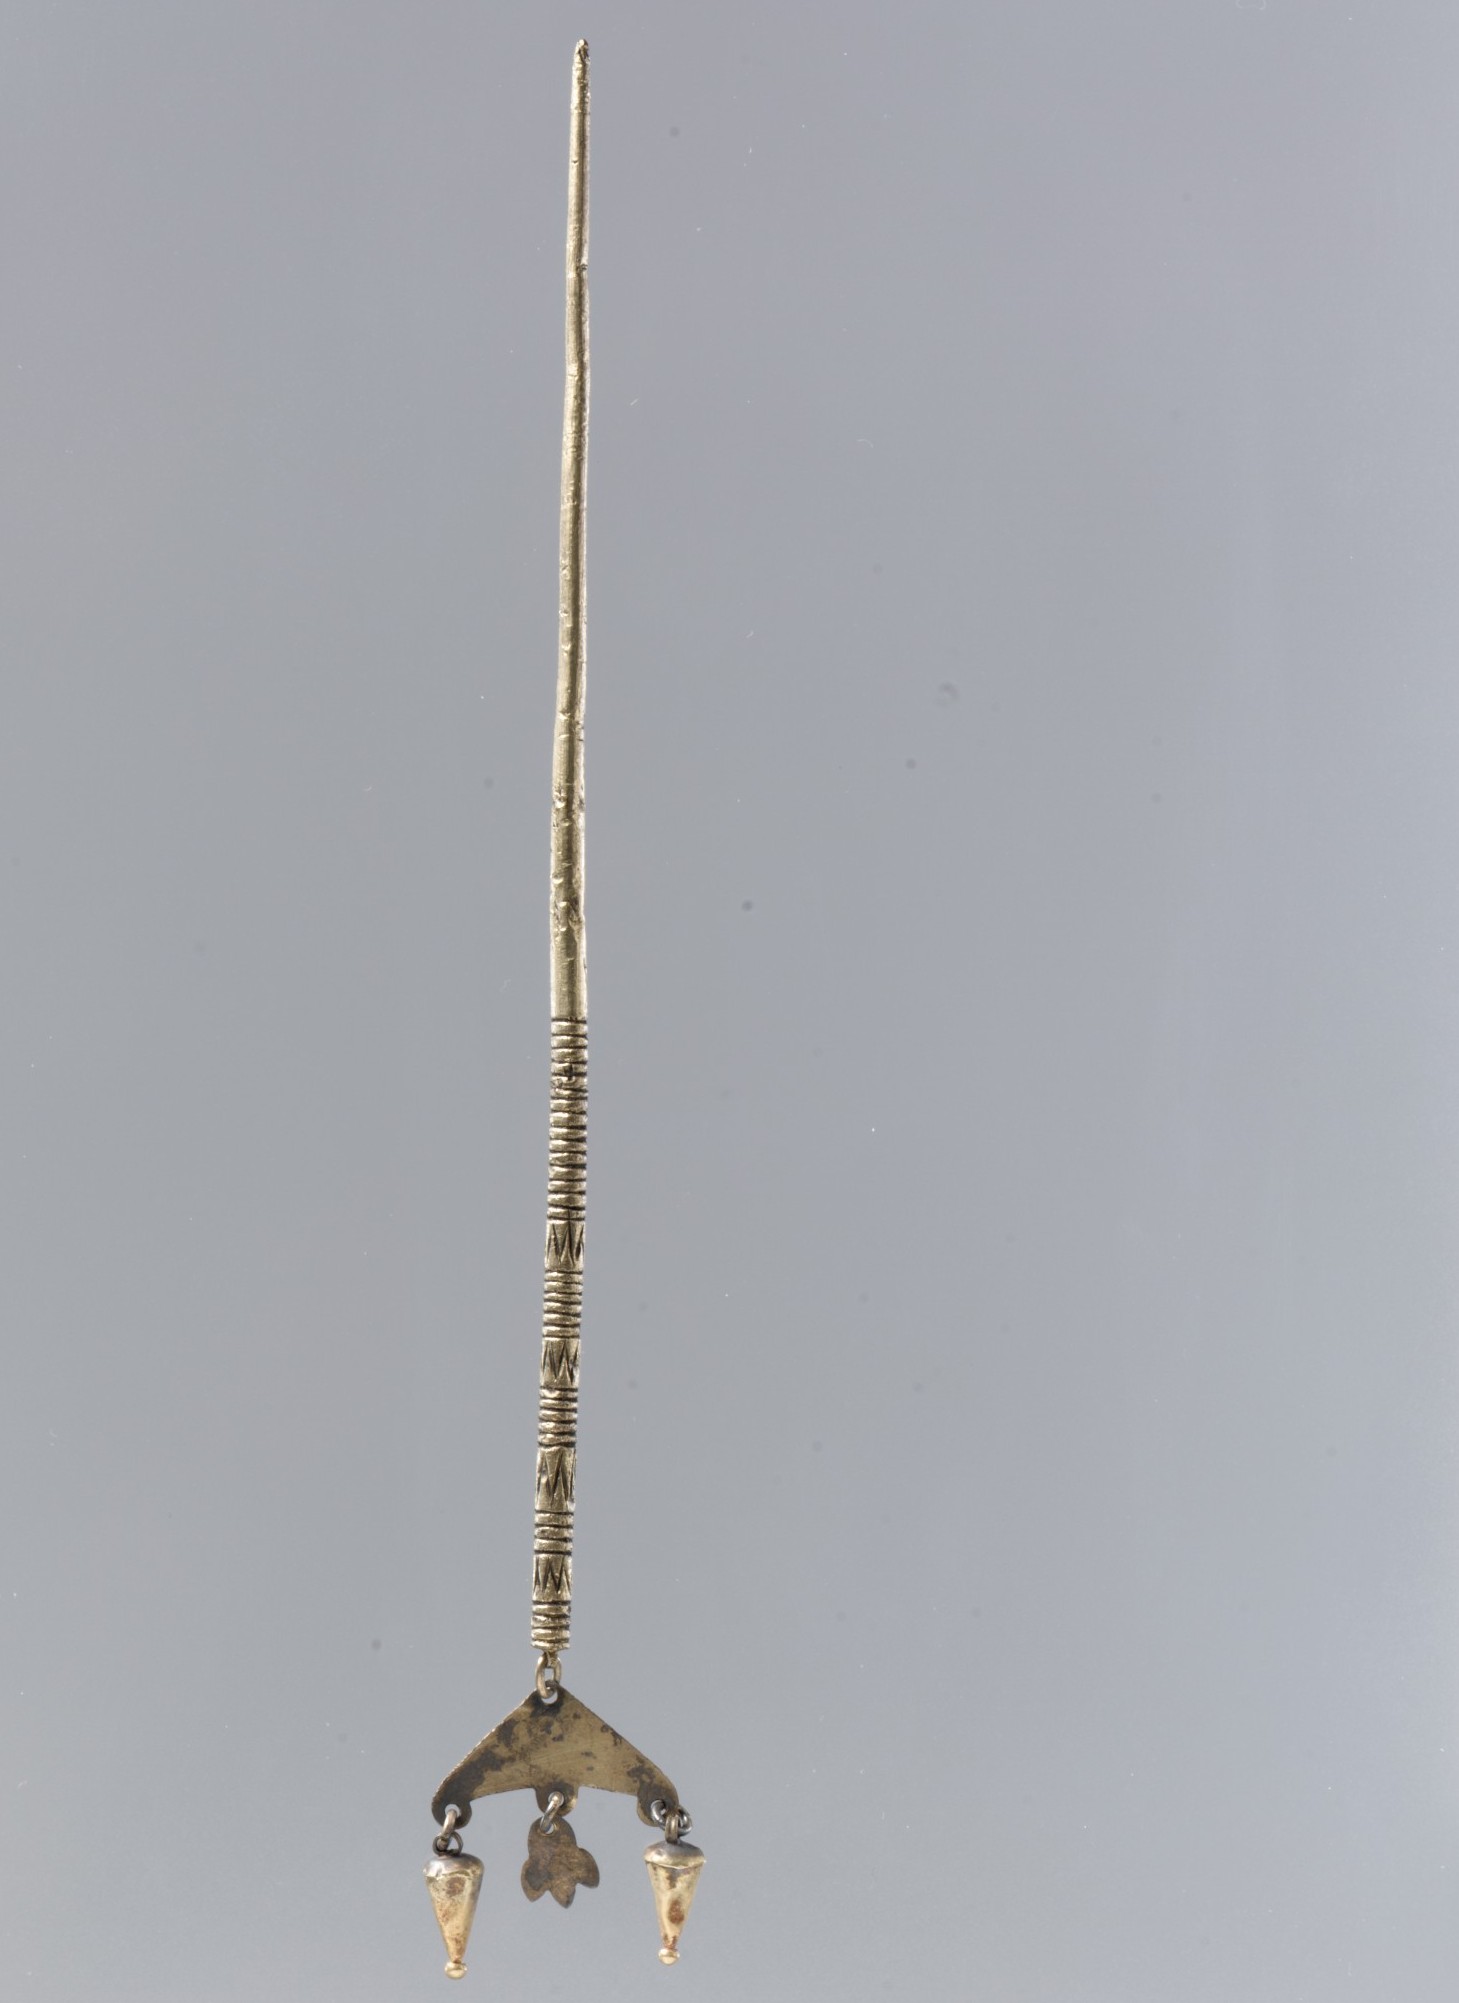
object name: hairpin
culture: frankish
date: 1886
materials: gold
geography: northern france